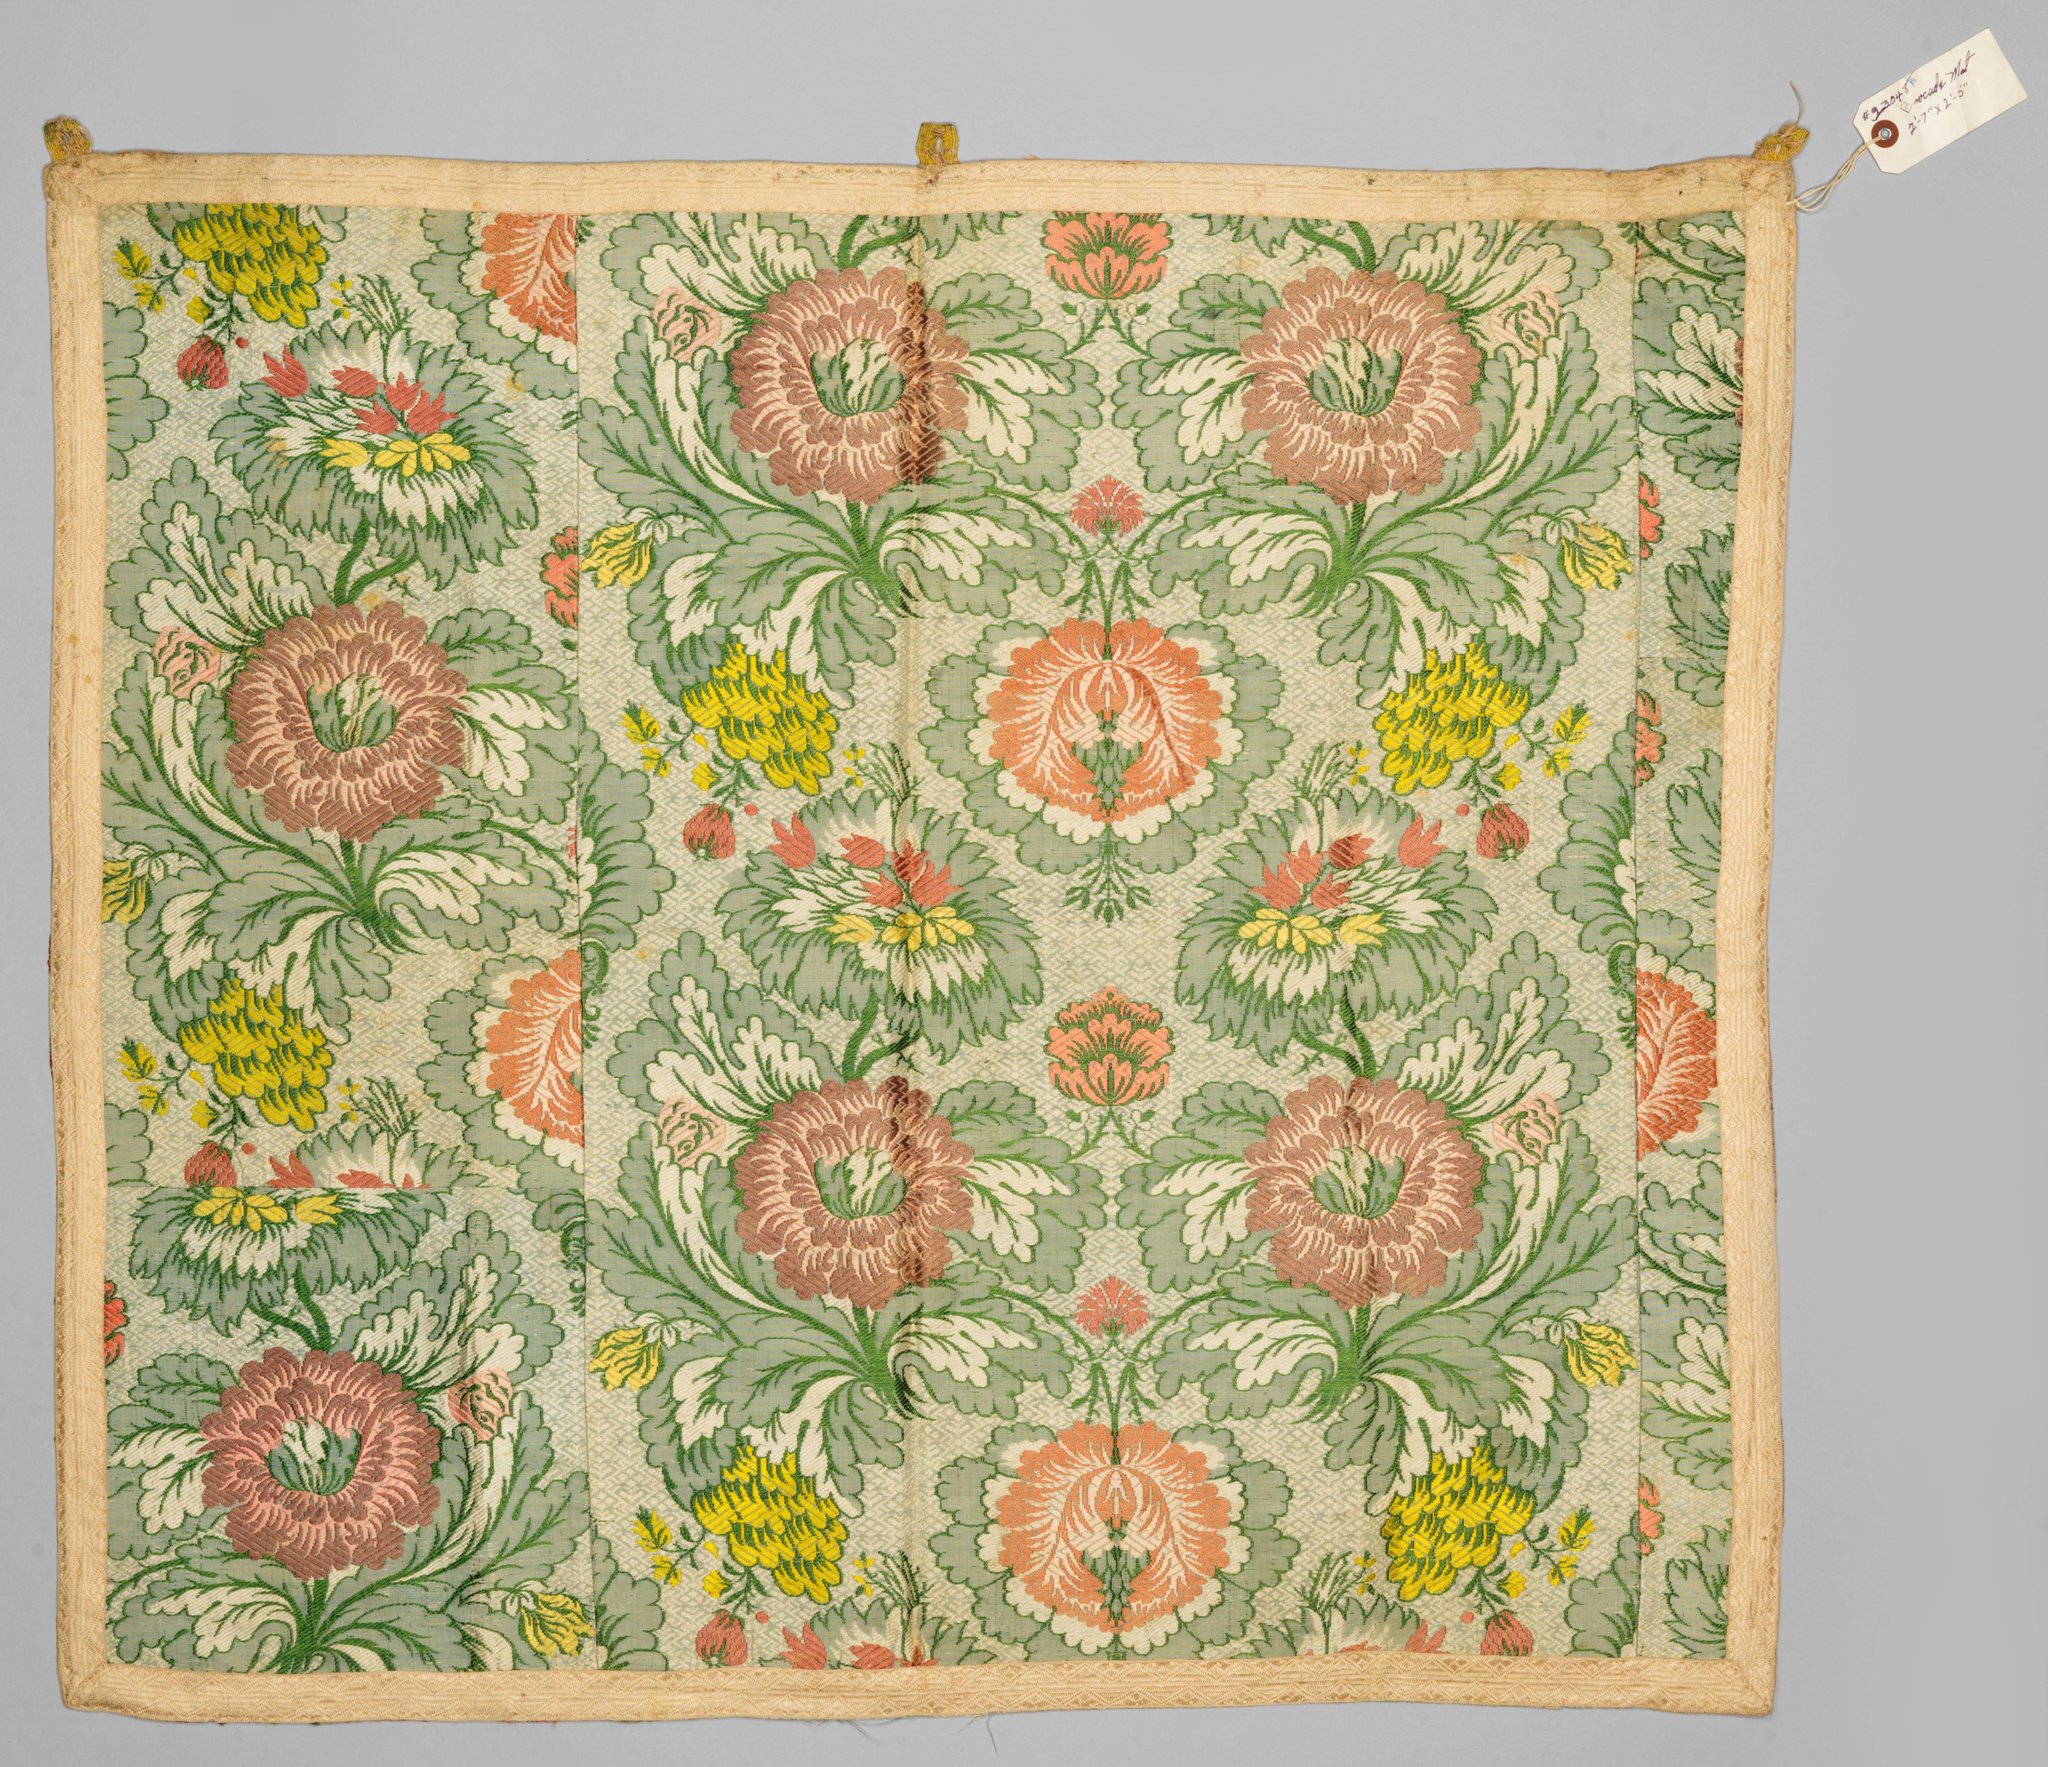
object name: fragment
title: Kleed of doek van gebrocheerde zijde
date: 1735-1745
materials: cotton, silk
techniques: brocade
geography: france